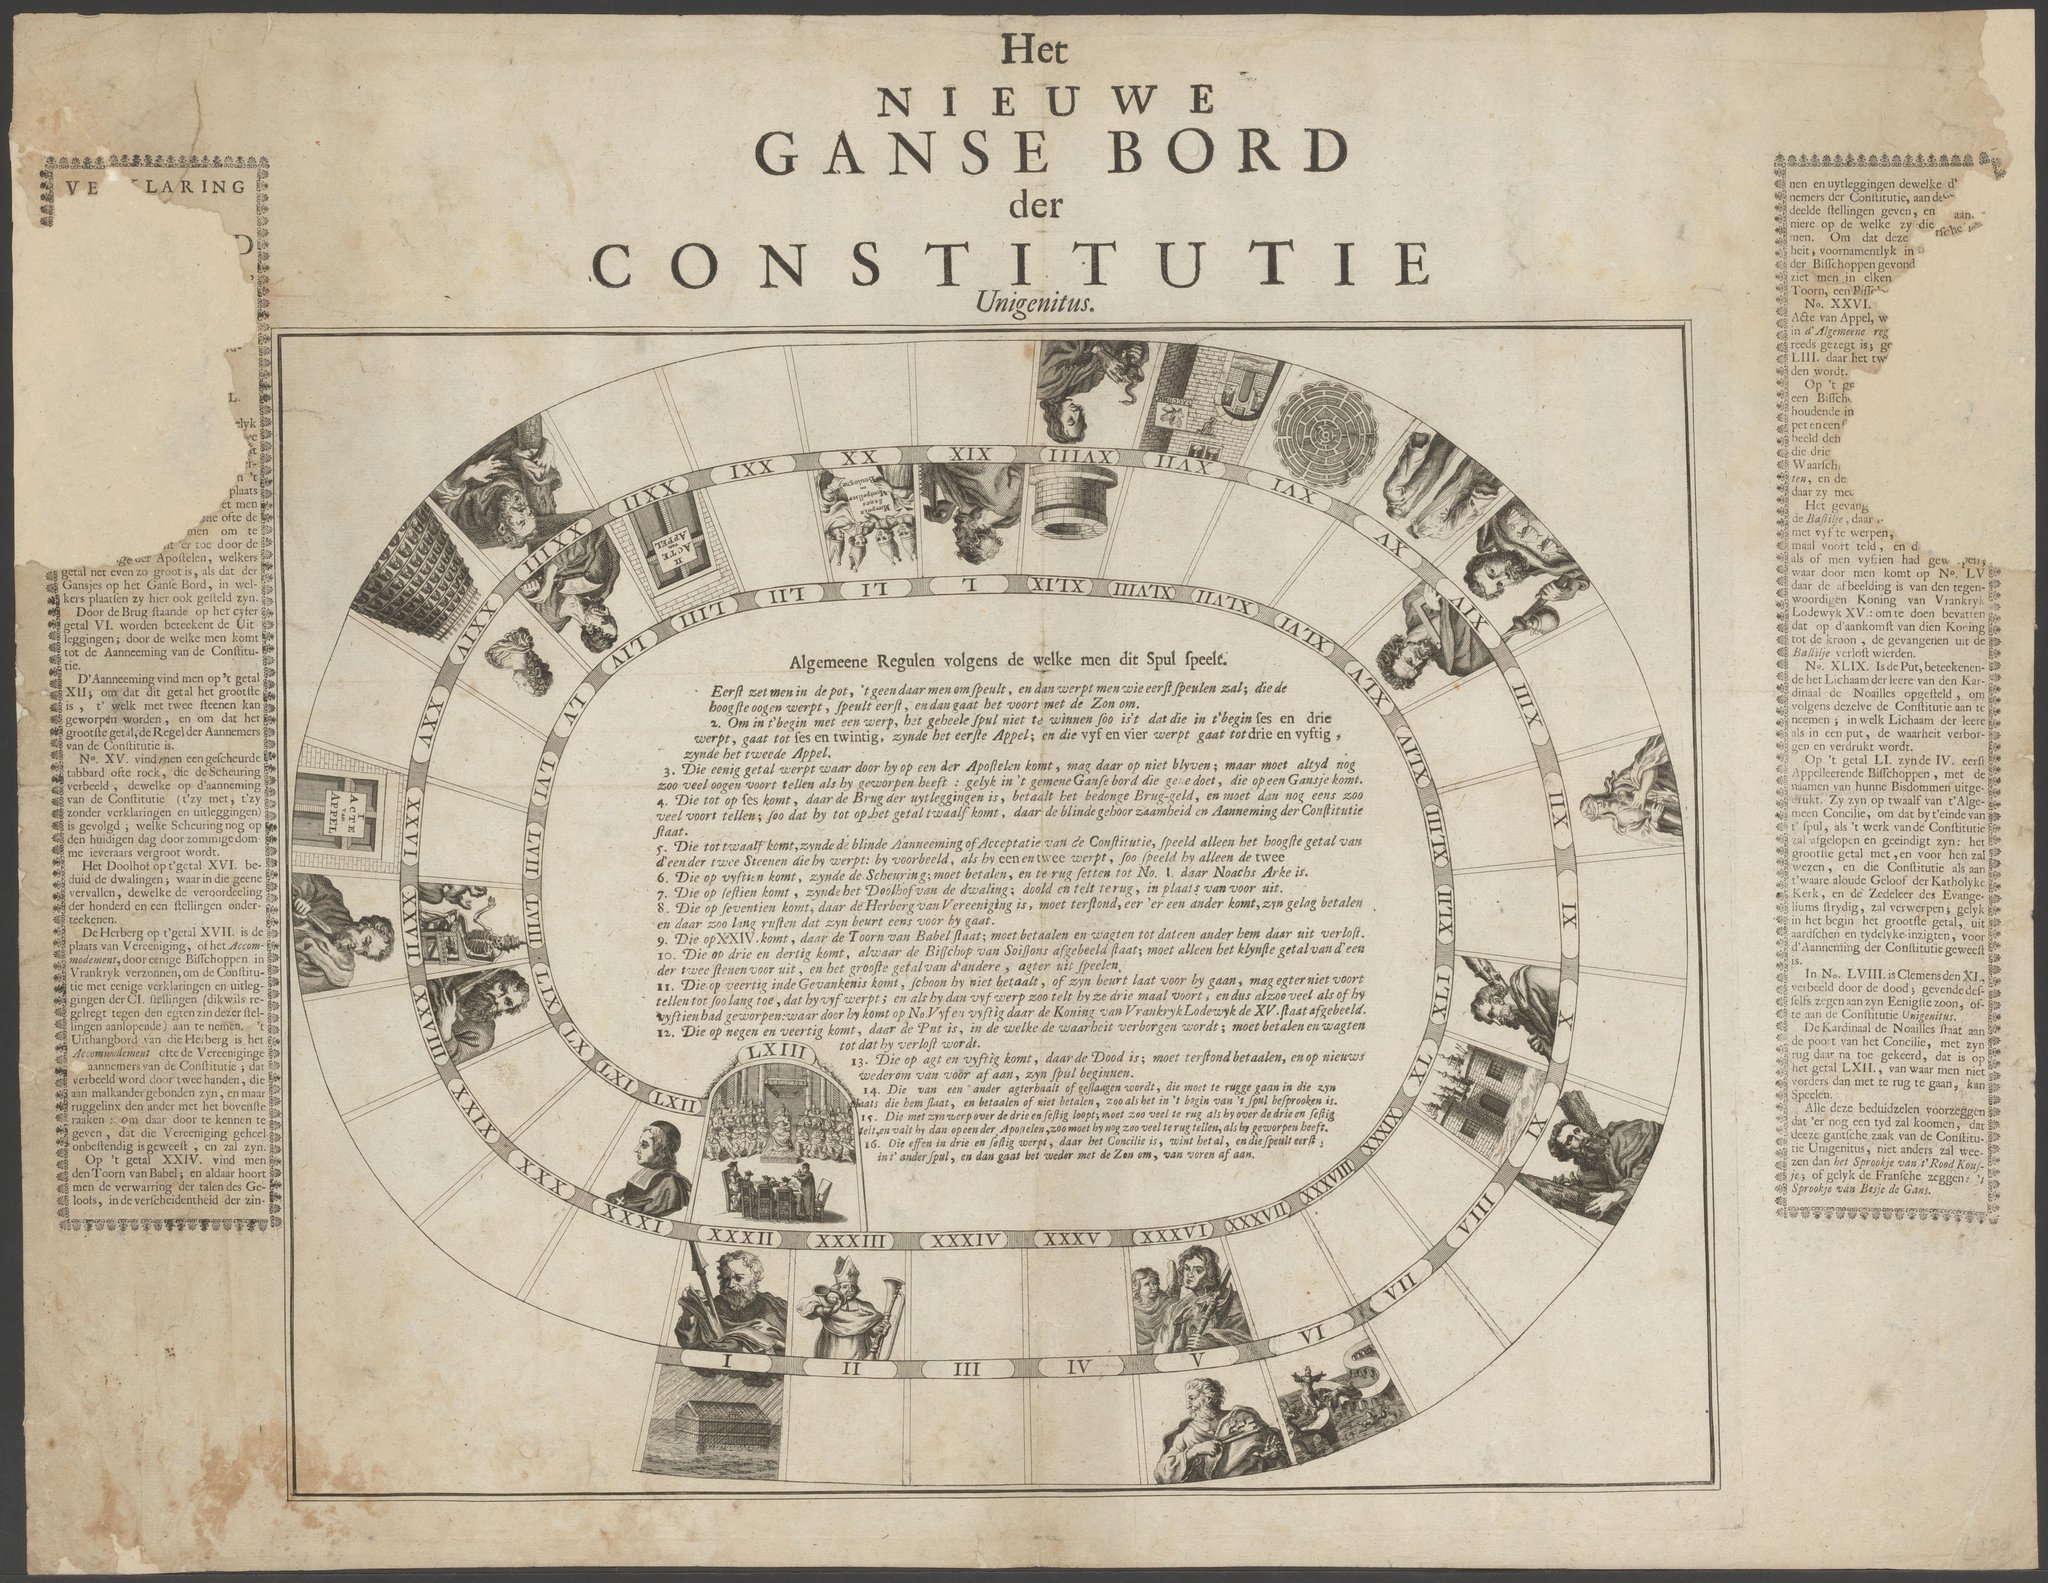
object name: print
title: Spotprent op de Bul of Constitutie Unigenitus van paus Clemens XI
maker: Anonymous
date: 1724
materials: paper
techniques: etching, letterpress printing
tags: goose-game, board-games of chance, board-games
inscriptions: stamp, collector's mark: Lugt 1641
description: Spotprent op de Bul of Constitutie Unigenitus van paus Clemens XI, ca. 1723-1724, in de vorm van een ganzenbord. Bordspel met 63 speelvakken die nog maar deels zijn ingevuld. In het midden van de spel staan de spelregels, in twee kolommen buiten het bord de verklaring van het spel. Onderwerpsrubrieken binnen de Atlas Zeden en Gewoonten: Zeden en gewoonten in engeren zin, Spel en vermaak, Gezelschapsspel II, Ganzenbord en dergelijke.